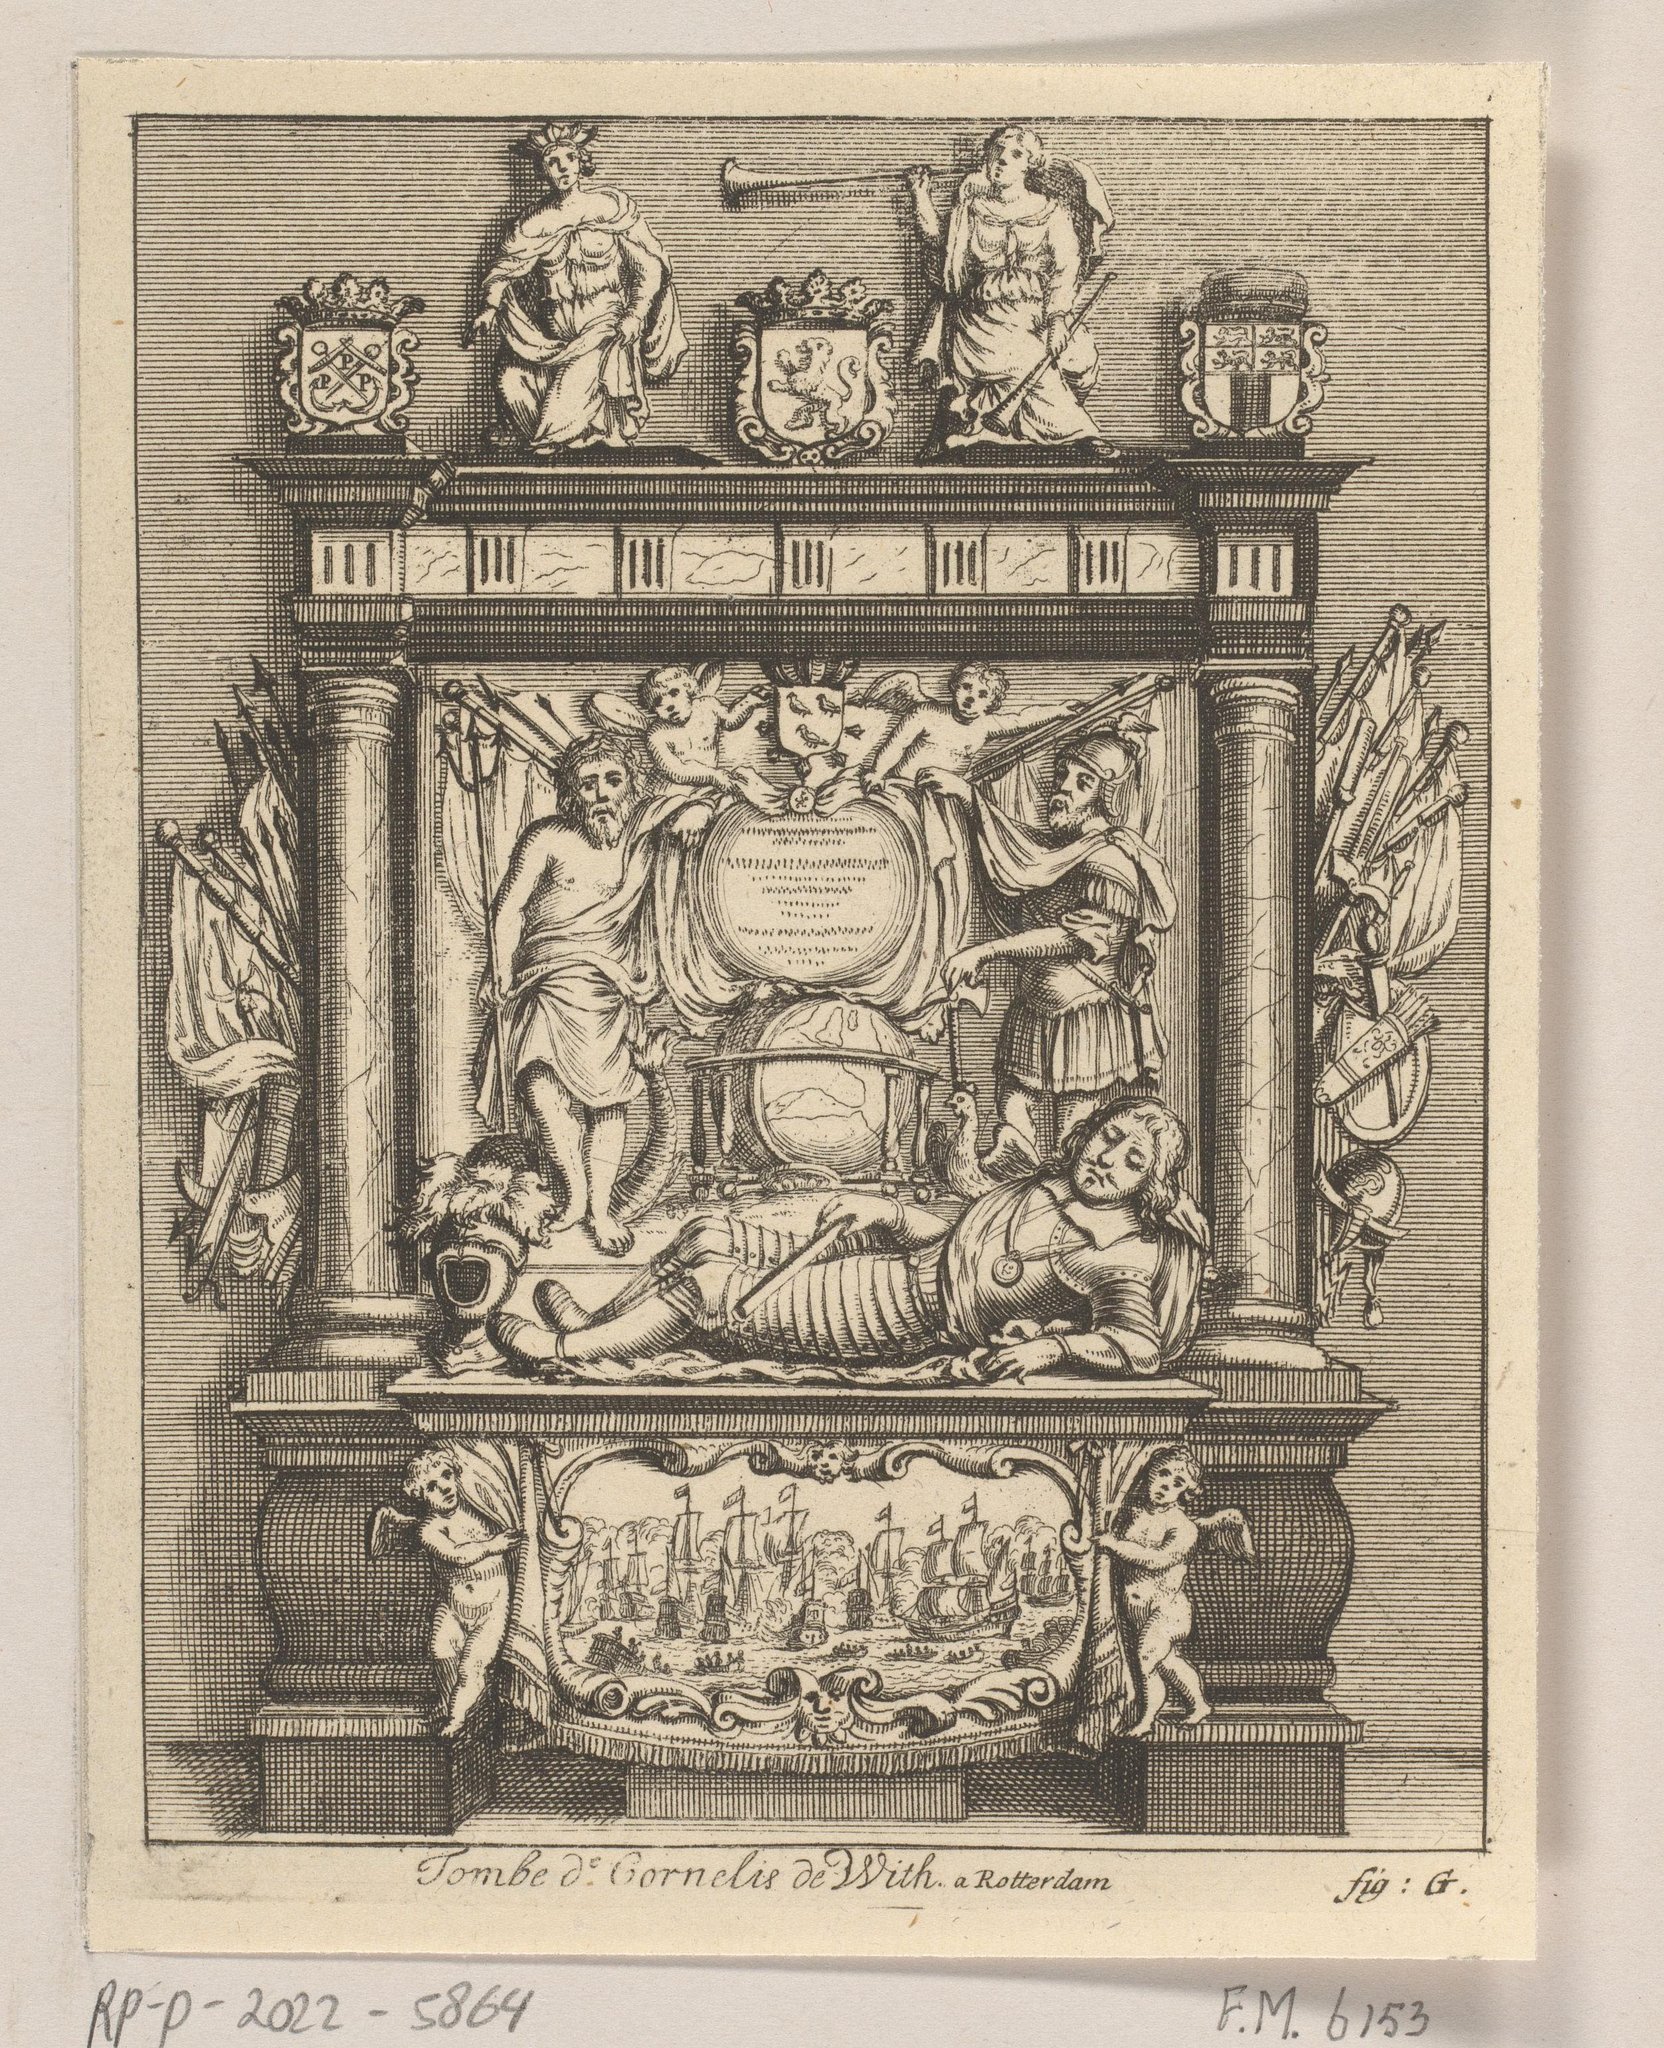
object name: book illustration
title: Portret van Witte Cornelisz. de With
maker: abraham bloteling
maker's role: draughtsman, print maker, publisher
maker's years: 1640-1690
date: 1690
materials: paper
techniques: etching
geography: amsterdam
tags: historical persons, mausoleum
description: Prent waarschijnlijk uit: Bizot, Pierre. Medalische historie der republyk van Holland (...). Amsterdam: Pieter Mortier, 1690, dl. 1.